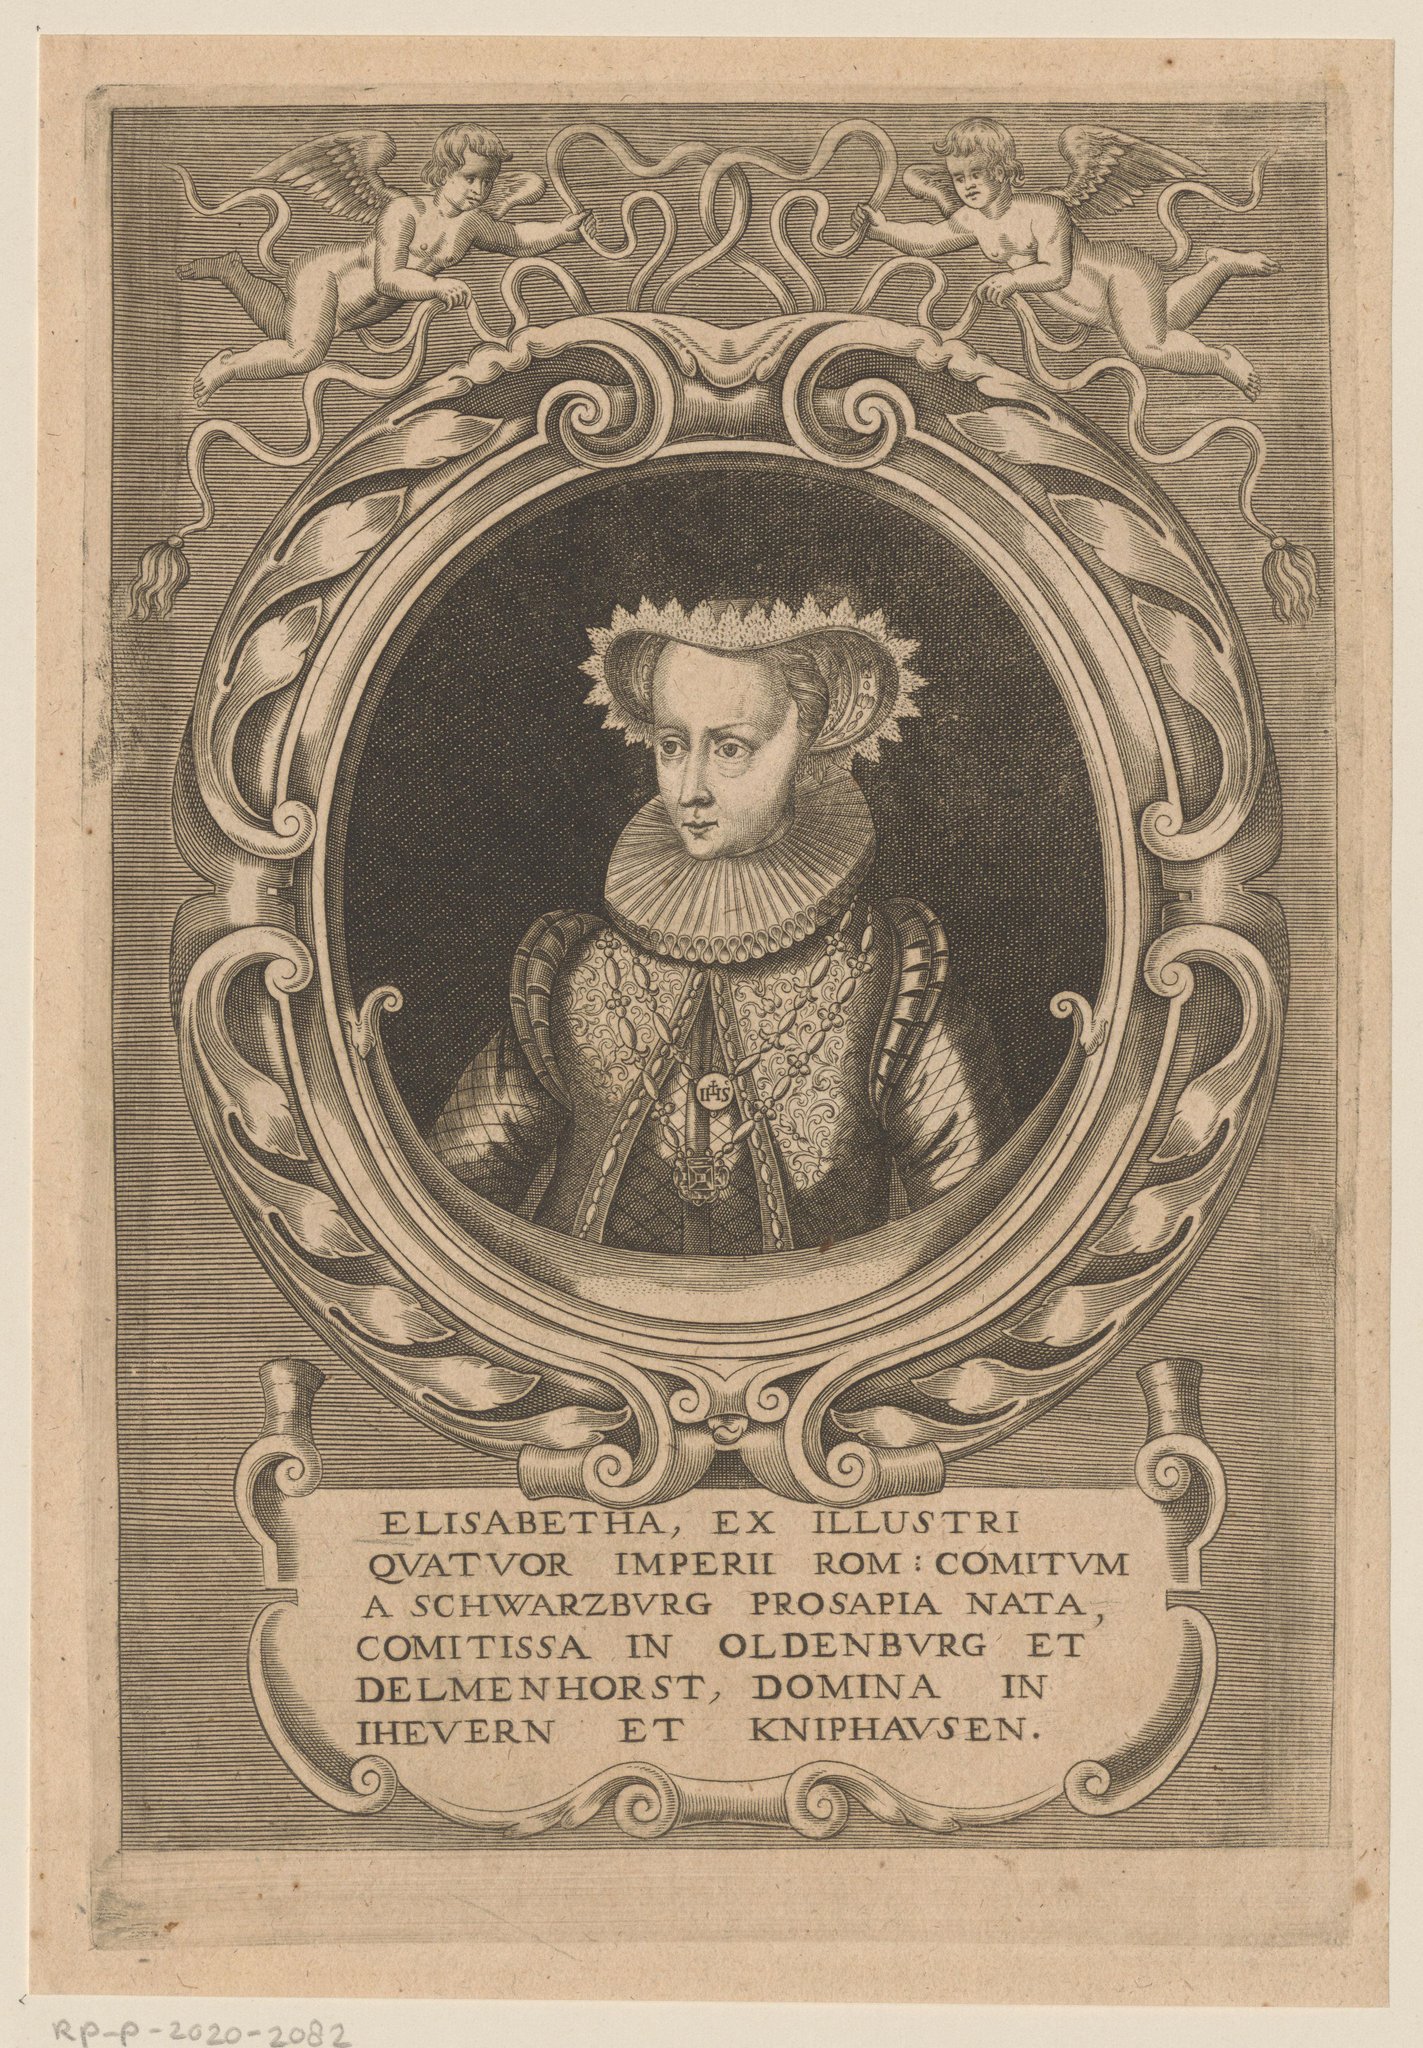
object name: print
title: Portret van Elisabeth von Schwarzburg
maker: Anonymous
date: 1671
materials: paper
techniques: engraving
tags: historical persons - bb - woman, cupids: 'amores', 'amoretti', 'putti'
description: Prent waarschijnlijk uit: Winckelmann, Johann Just. Oldenburgische Friedens- und der benachbarten Oerter Kriegs-Handlungen. Oldenburg: Hans Erich Zimmer, 1671, tussen p. 22 en 23.